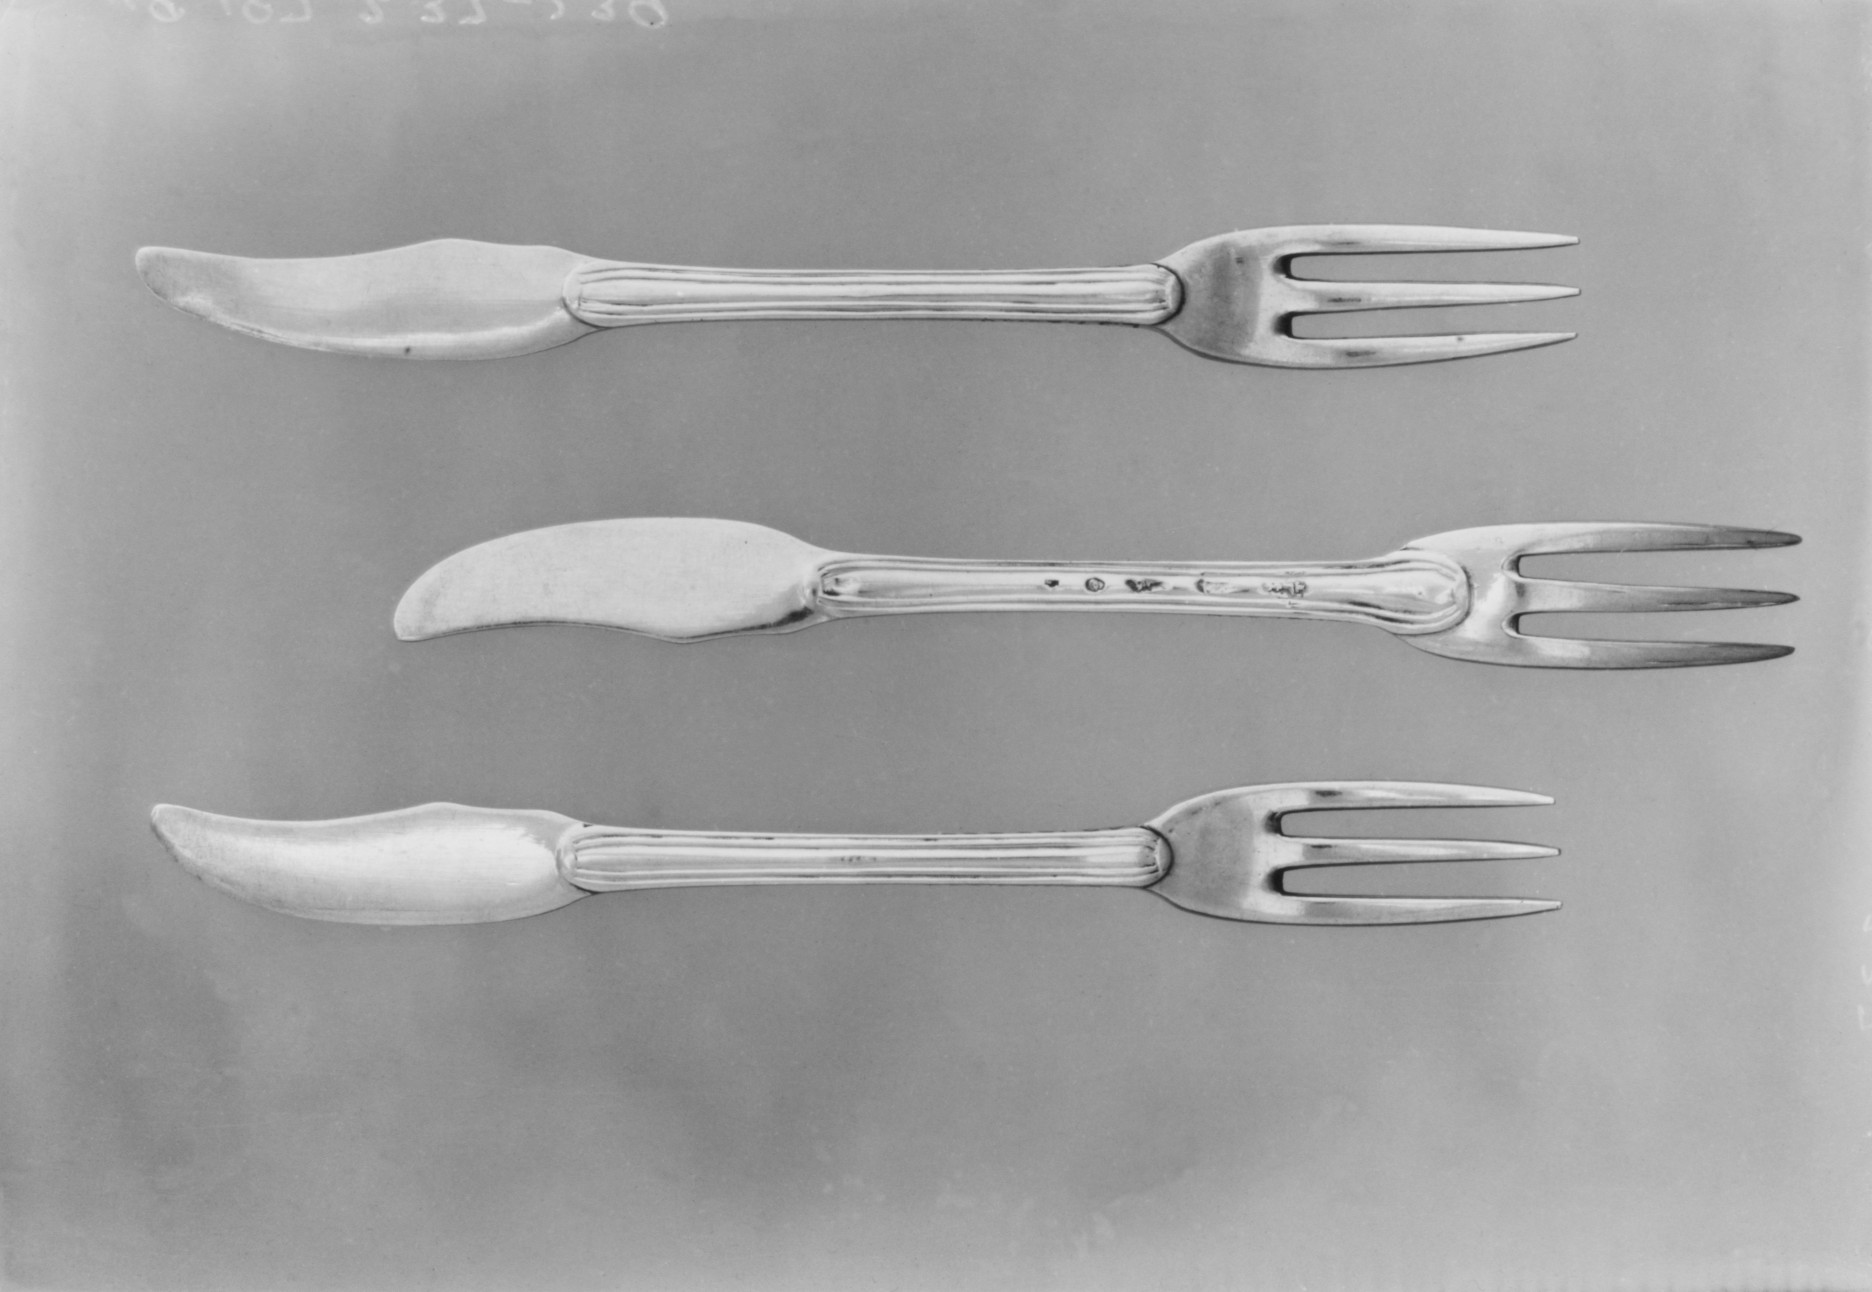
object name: fork with knife handle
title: Fork with knife handle (one of six)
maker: louis-antoine taillepied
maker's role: maker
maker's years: 1734-1834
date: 1778-1779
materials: silver